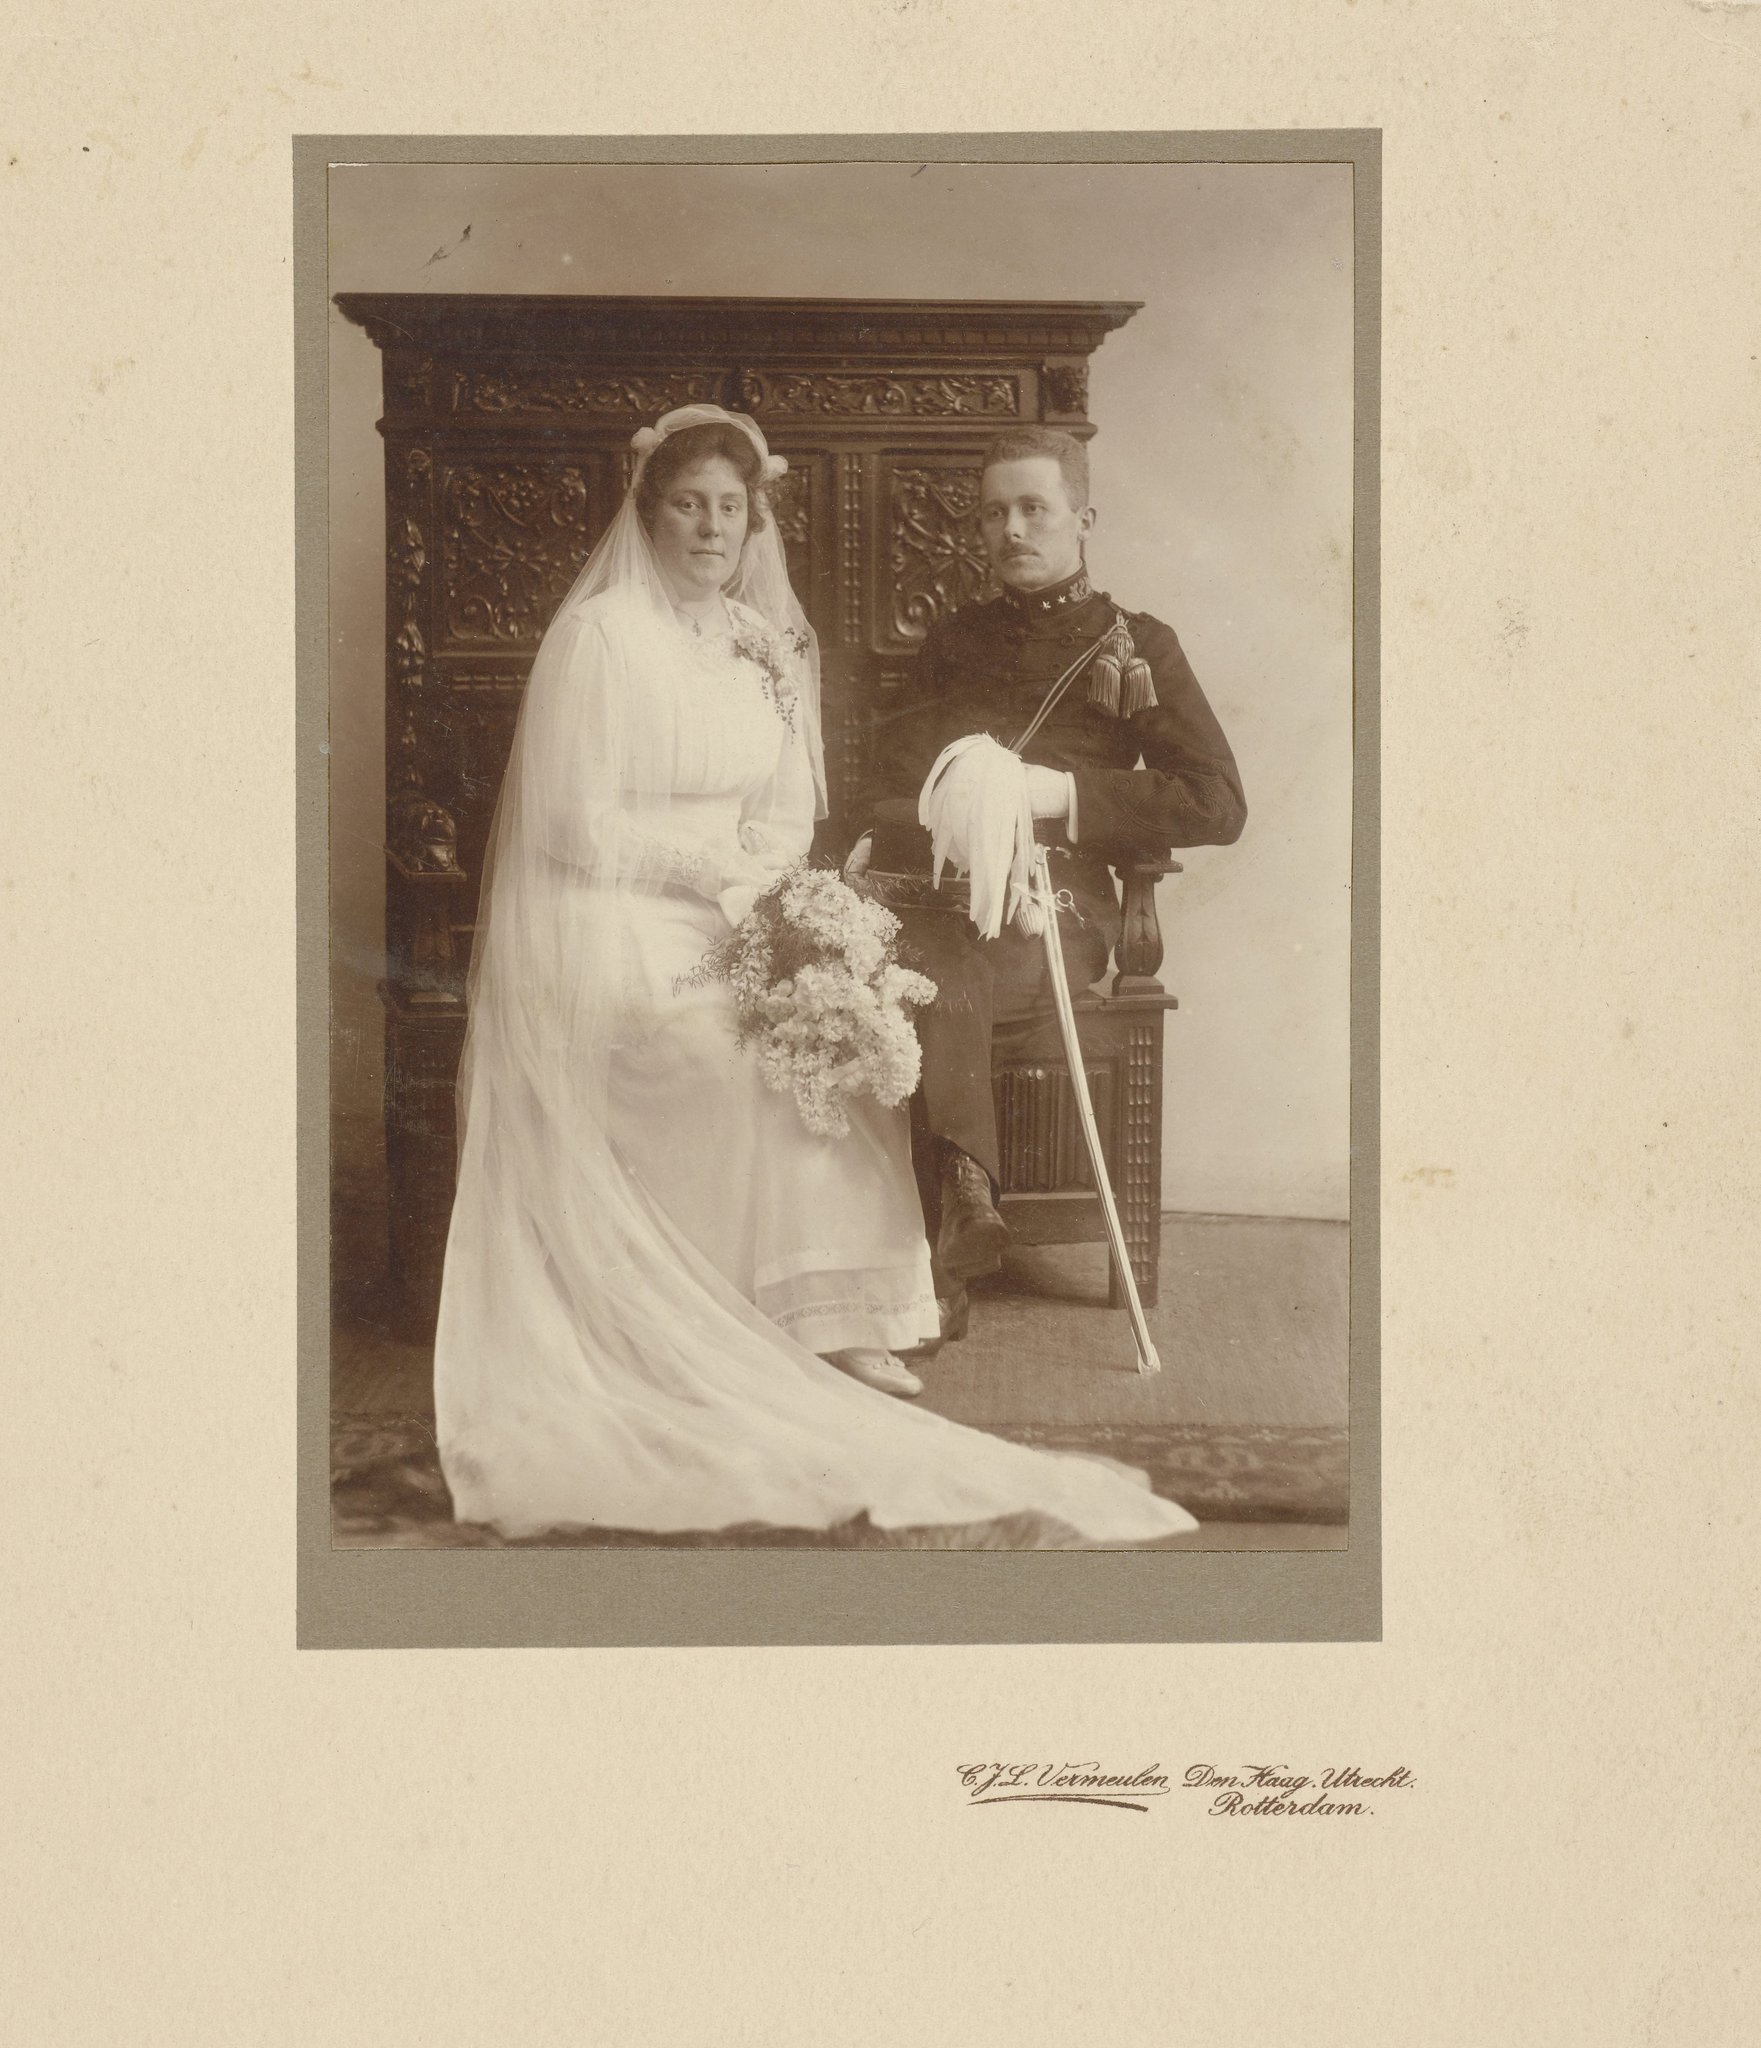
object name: photograph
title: Bruidsportret van Tine Vermeulen en Klaas Kleiterp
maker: cornelis johannes lodewicus vermeulen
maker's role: fotograaf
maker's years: 1861-1936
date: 1918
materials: cardboard, photographic support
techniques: collodion silver print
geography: the hague